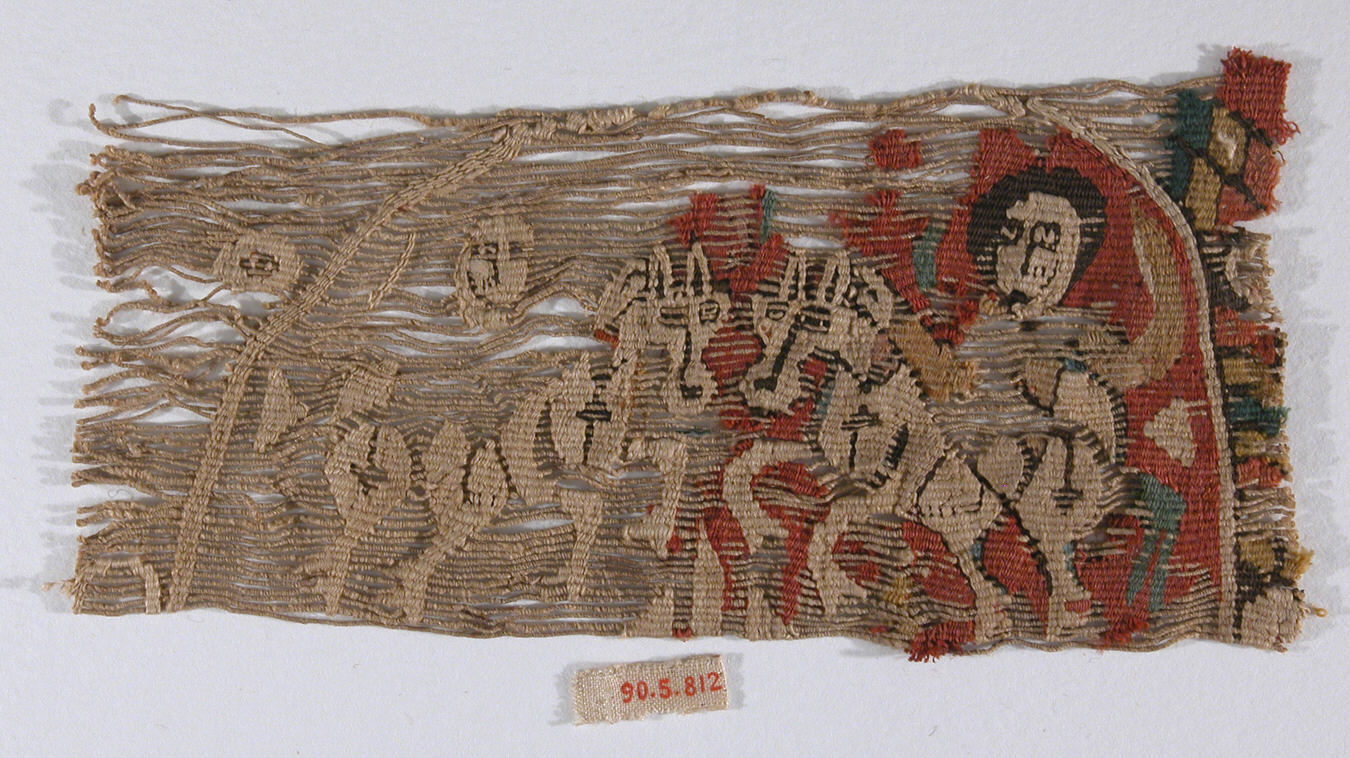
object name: textile fragment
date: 501-700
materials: linen, wool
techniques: weave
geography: egypt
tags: human figures,horses